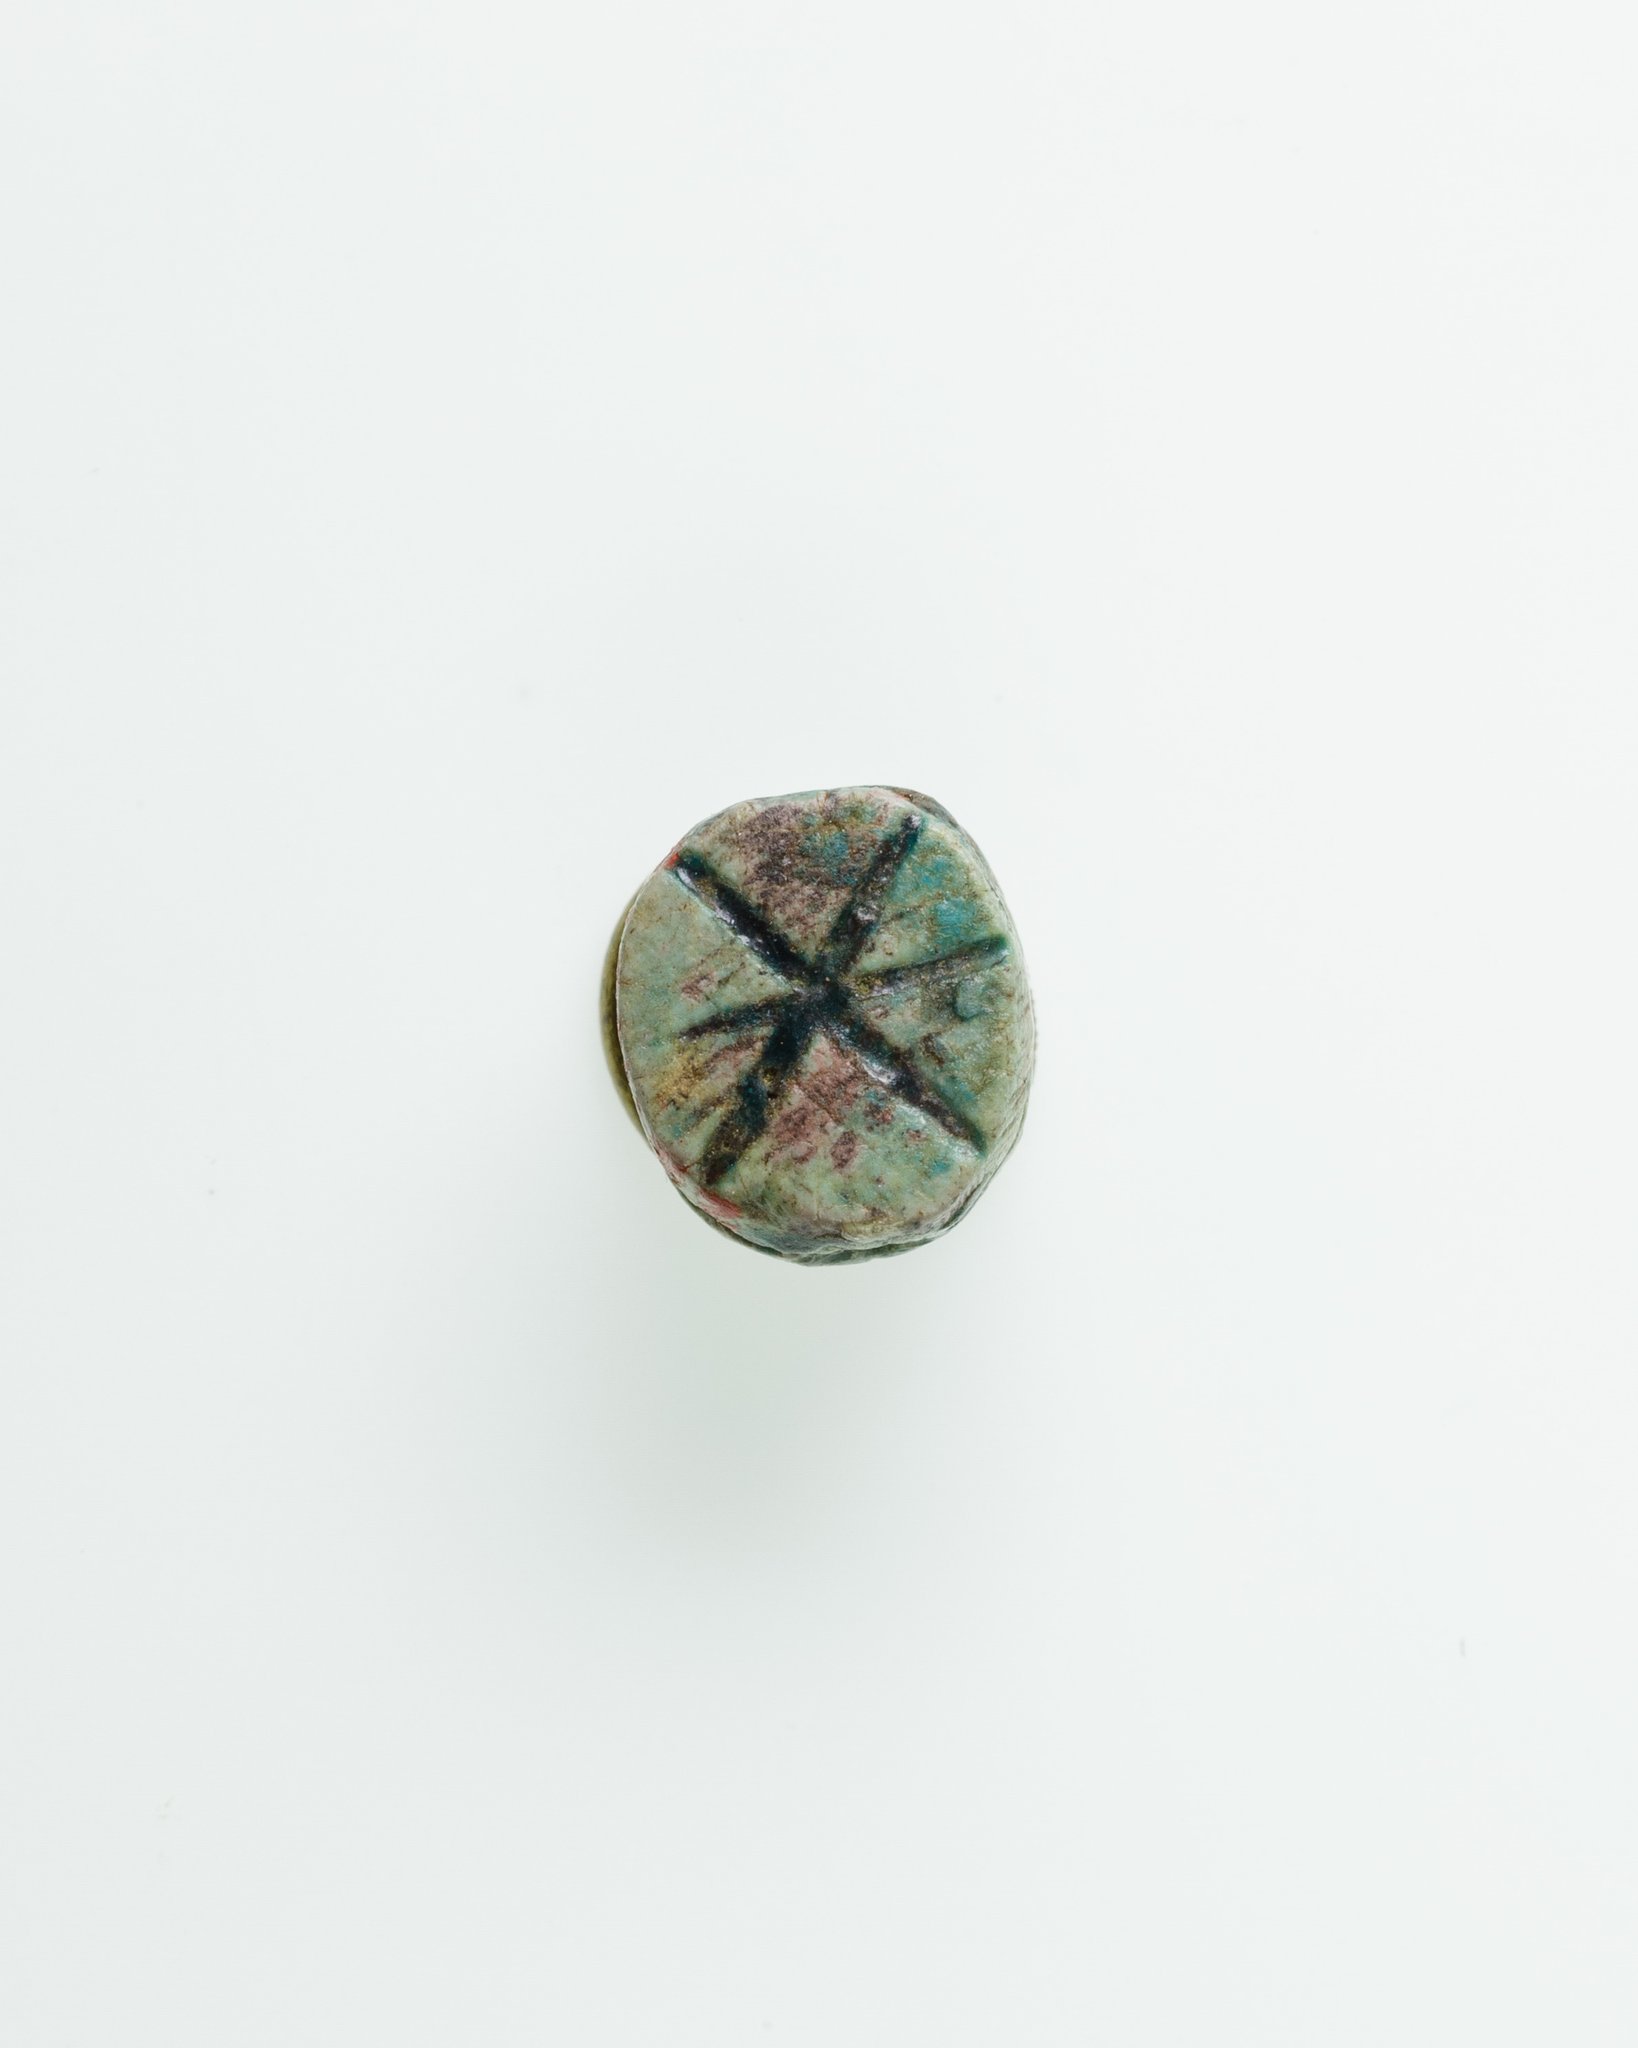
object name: scarab, geometric, cross, linear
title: Scarab Decorated with Crossing Lines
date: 1070-900 BCE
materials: stone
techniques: glazing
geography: egypt